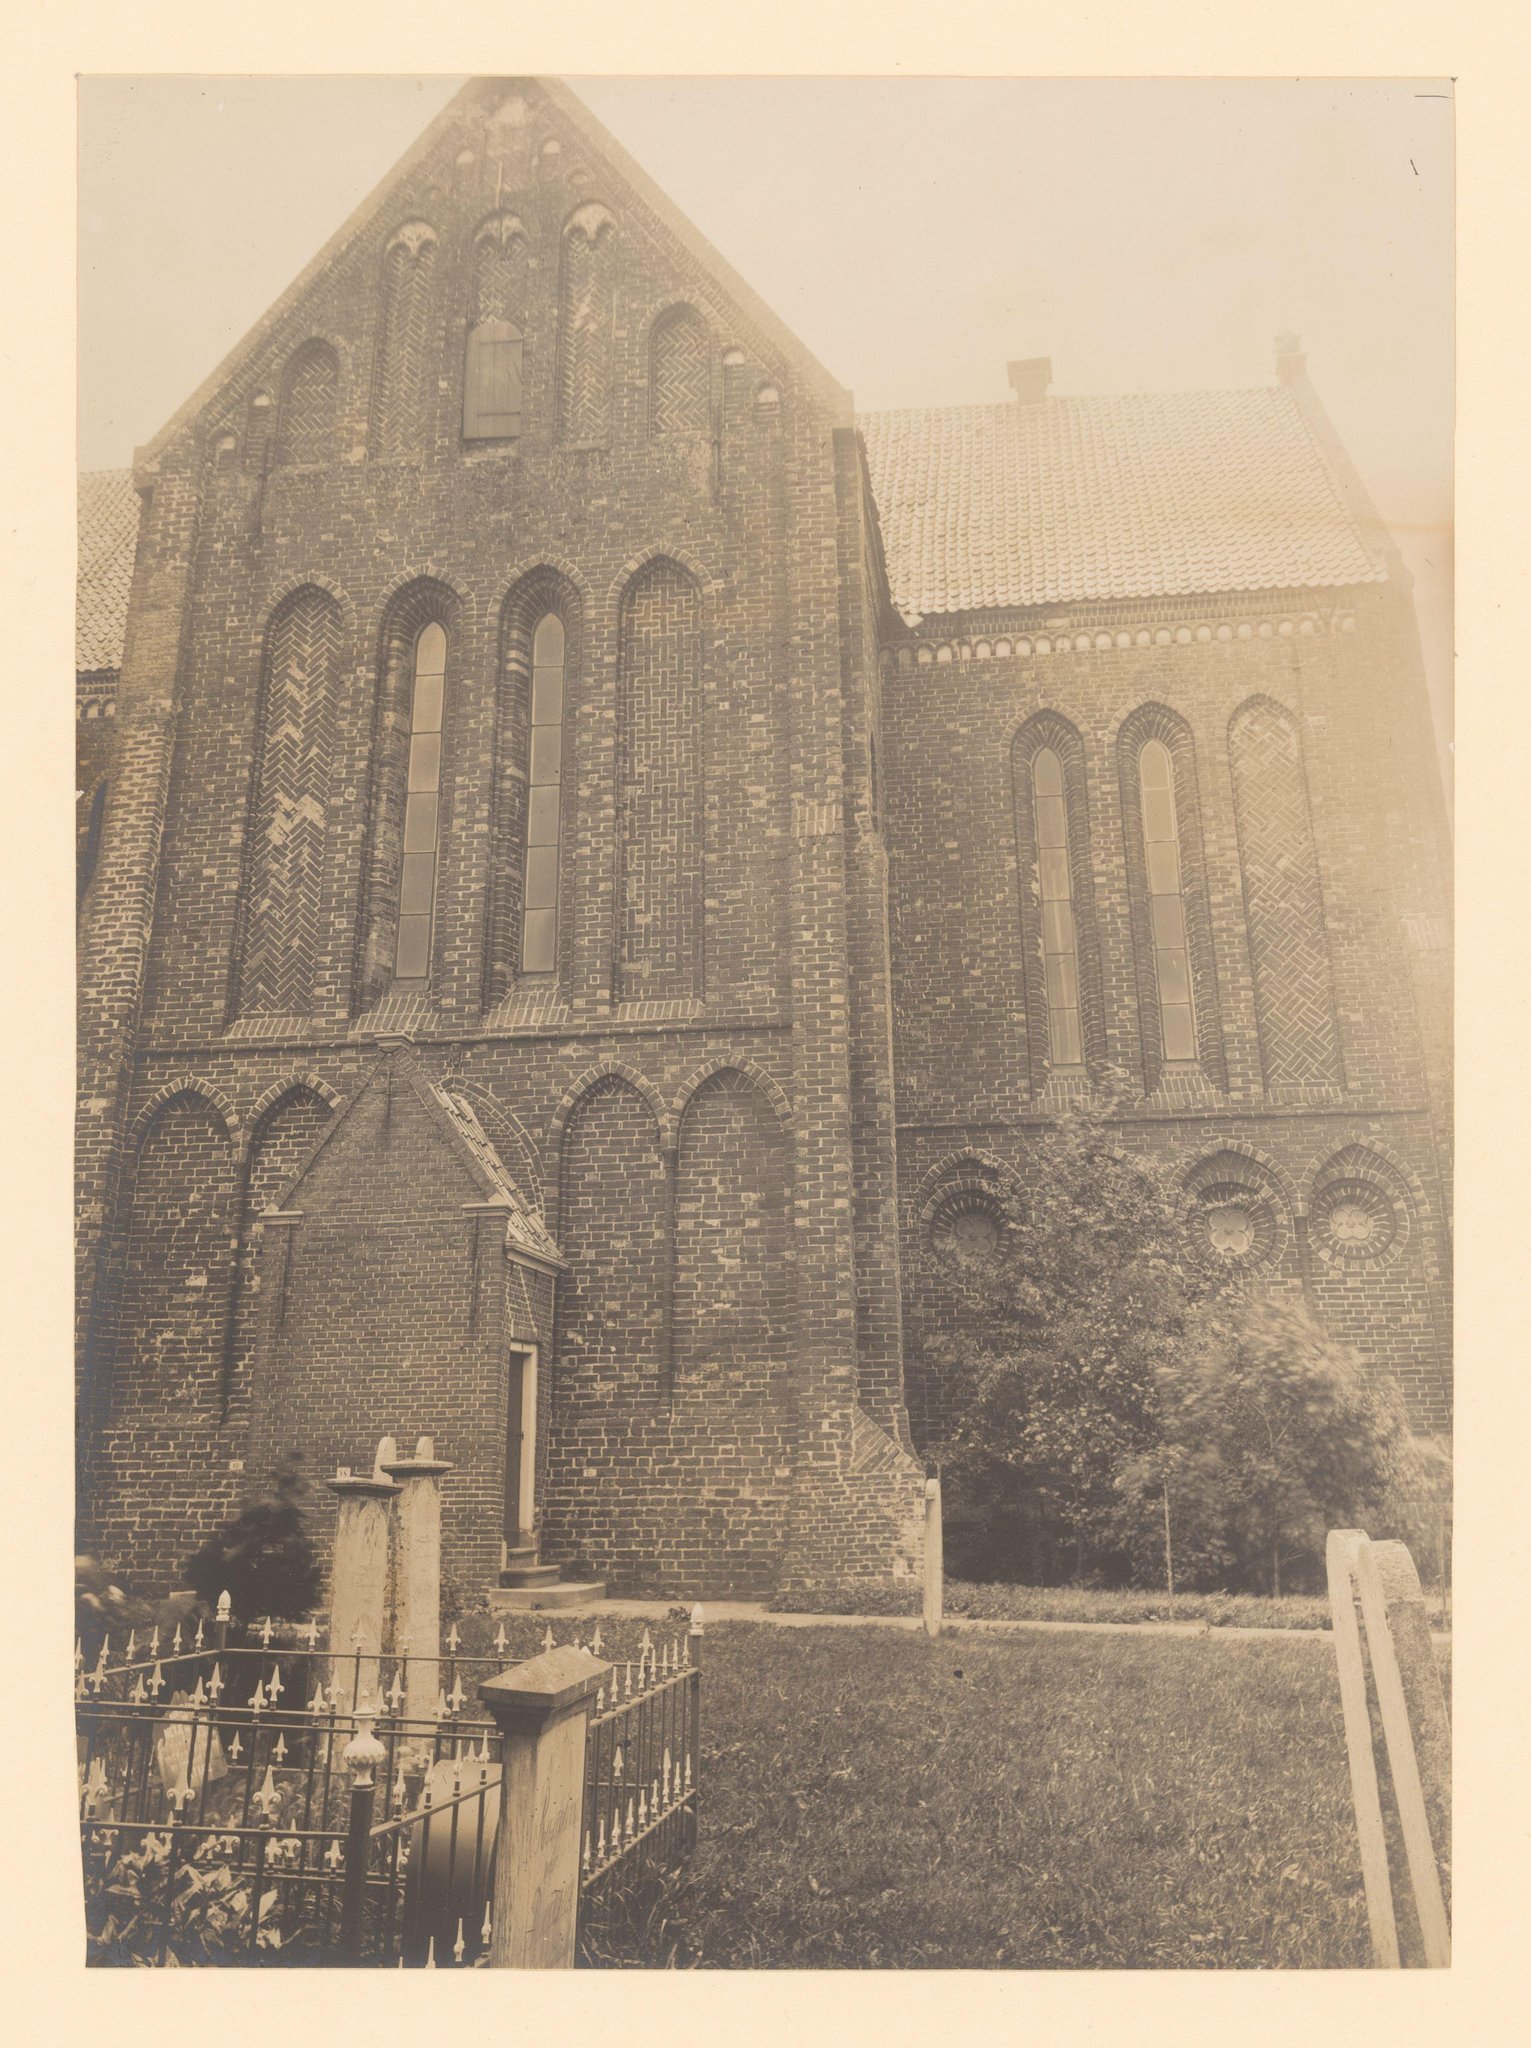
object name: photograph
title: Zuidzijde van de Petruskerk te Zuidbroek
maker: anoniem (monumentenzorg)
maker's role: fotograaf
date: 1893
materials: cardboard, photographic support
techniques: albumen print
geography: zuidbroek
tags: church (exterior)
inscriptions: annotation: ‘Zuidbroek/ N.H. kerk (zuidzijde/ juli 1907’, annotation: ‘Zuidbroek’